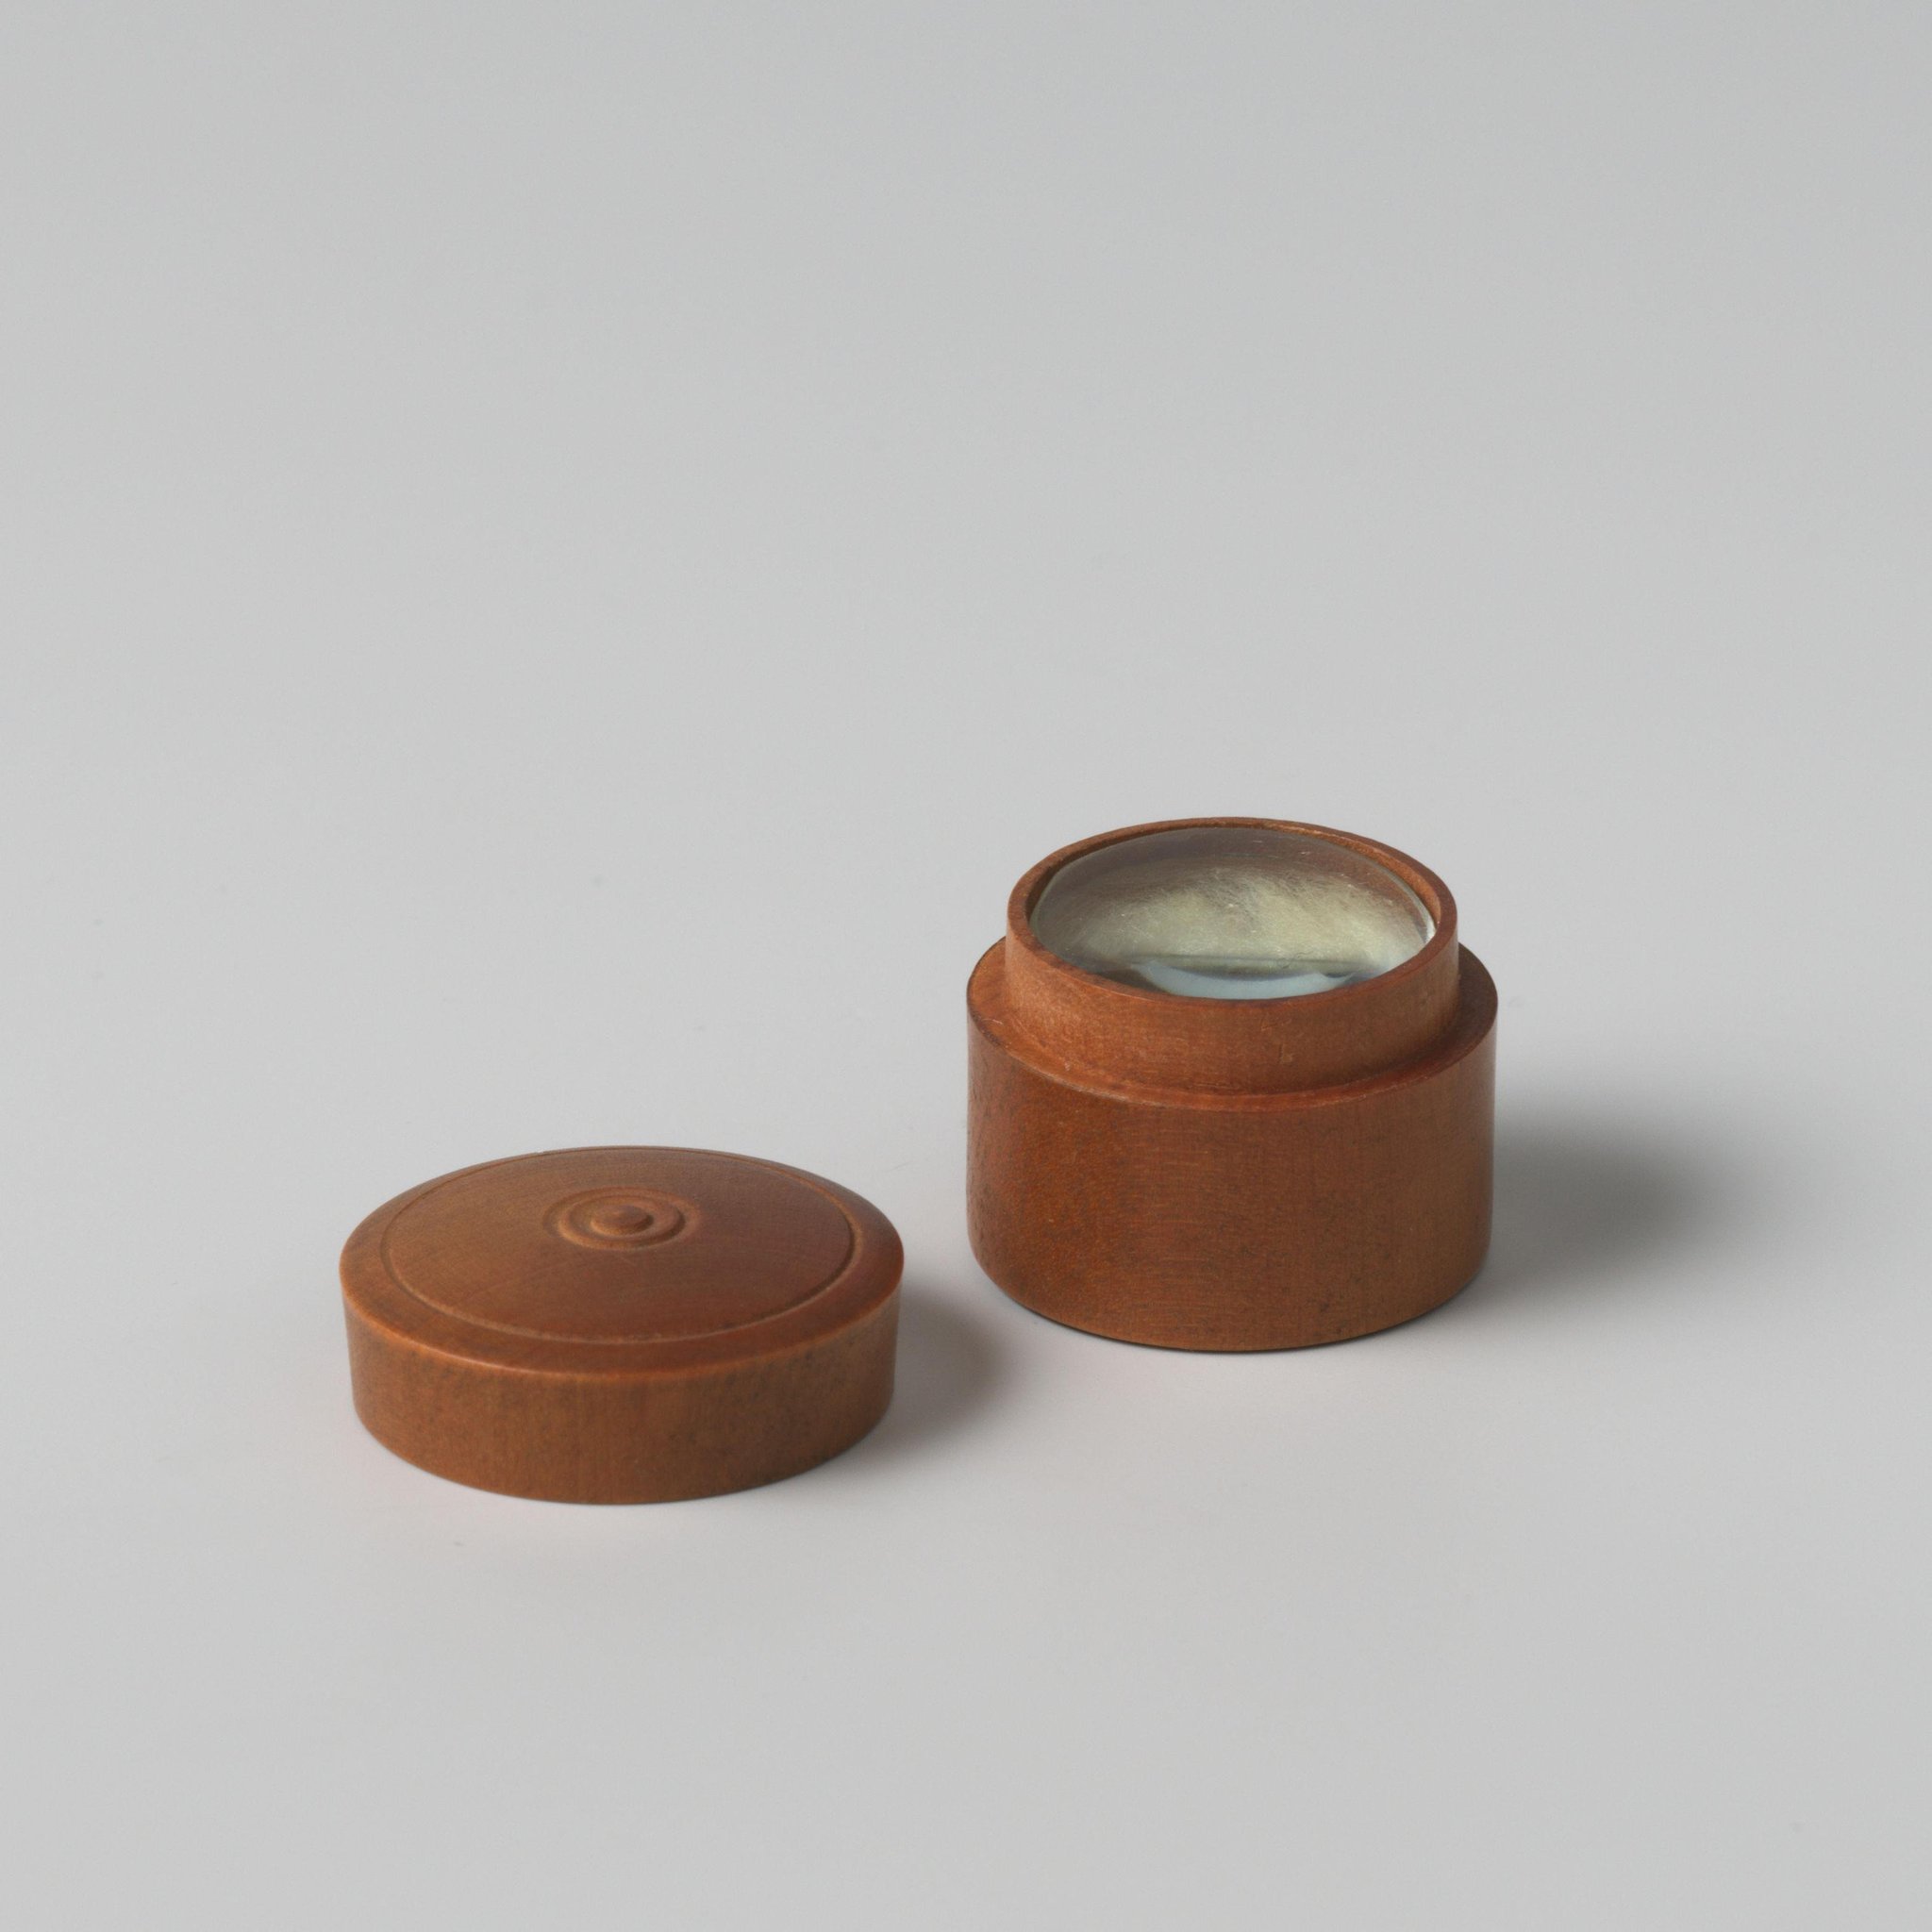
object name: box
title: Doos met curiositeiten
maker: Anonymous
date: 1600-1699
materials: wood, cotton, glass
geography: southern germany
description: Ronde doos met deksel, gedraaid van palmhout, waarin twee lenzen of vergrootglazen op katoenpluis. De platte deksel met drie gegroefde cirkels.